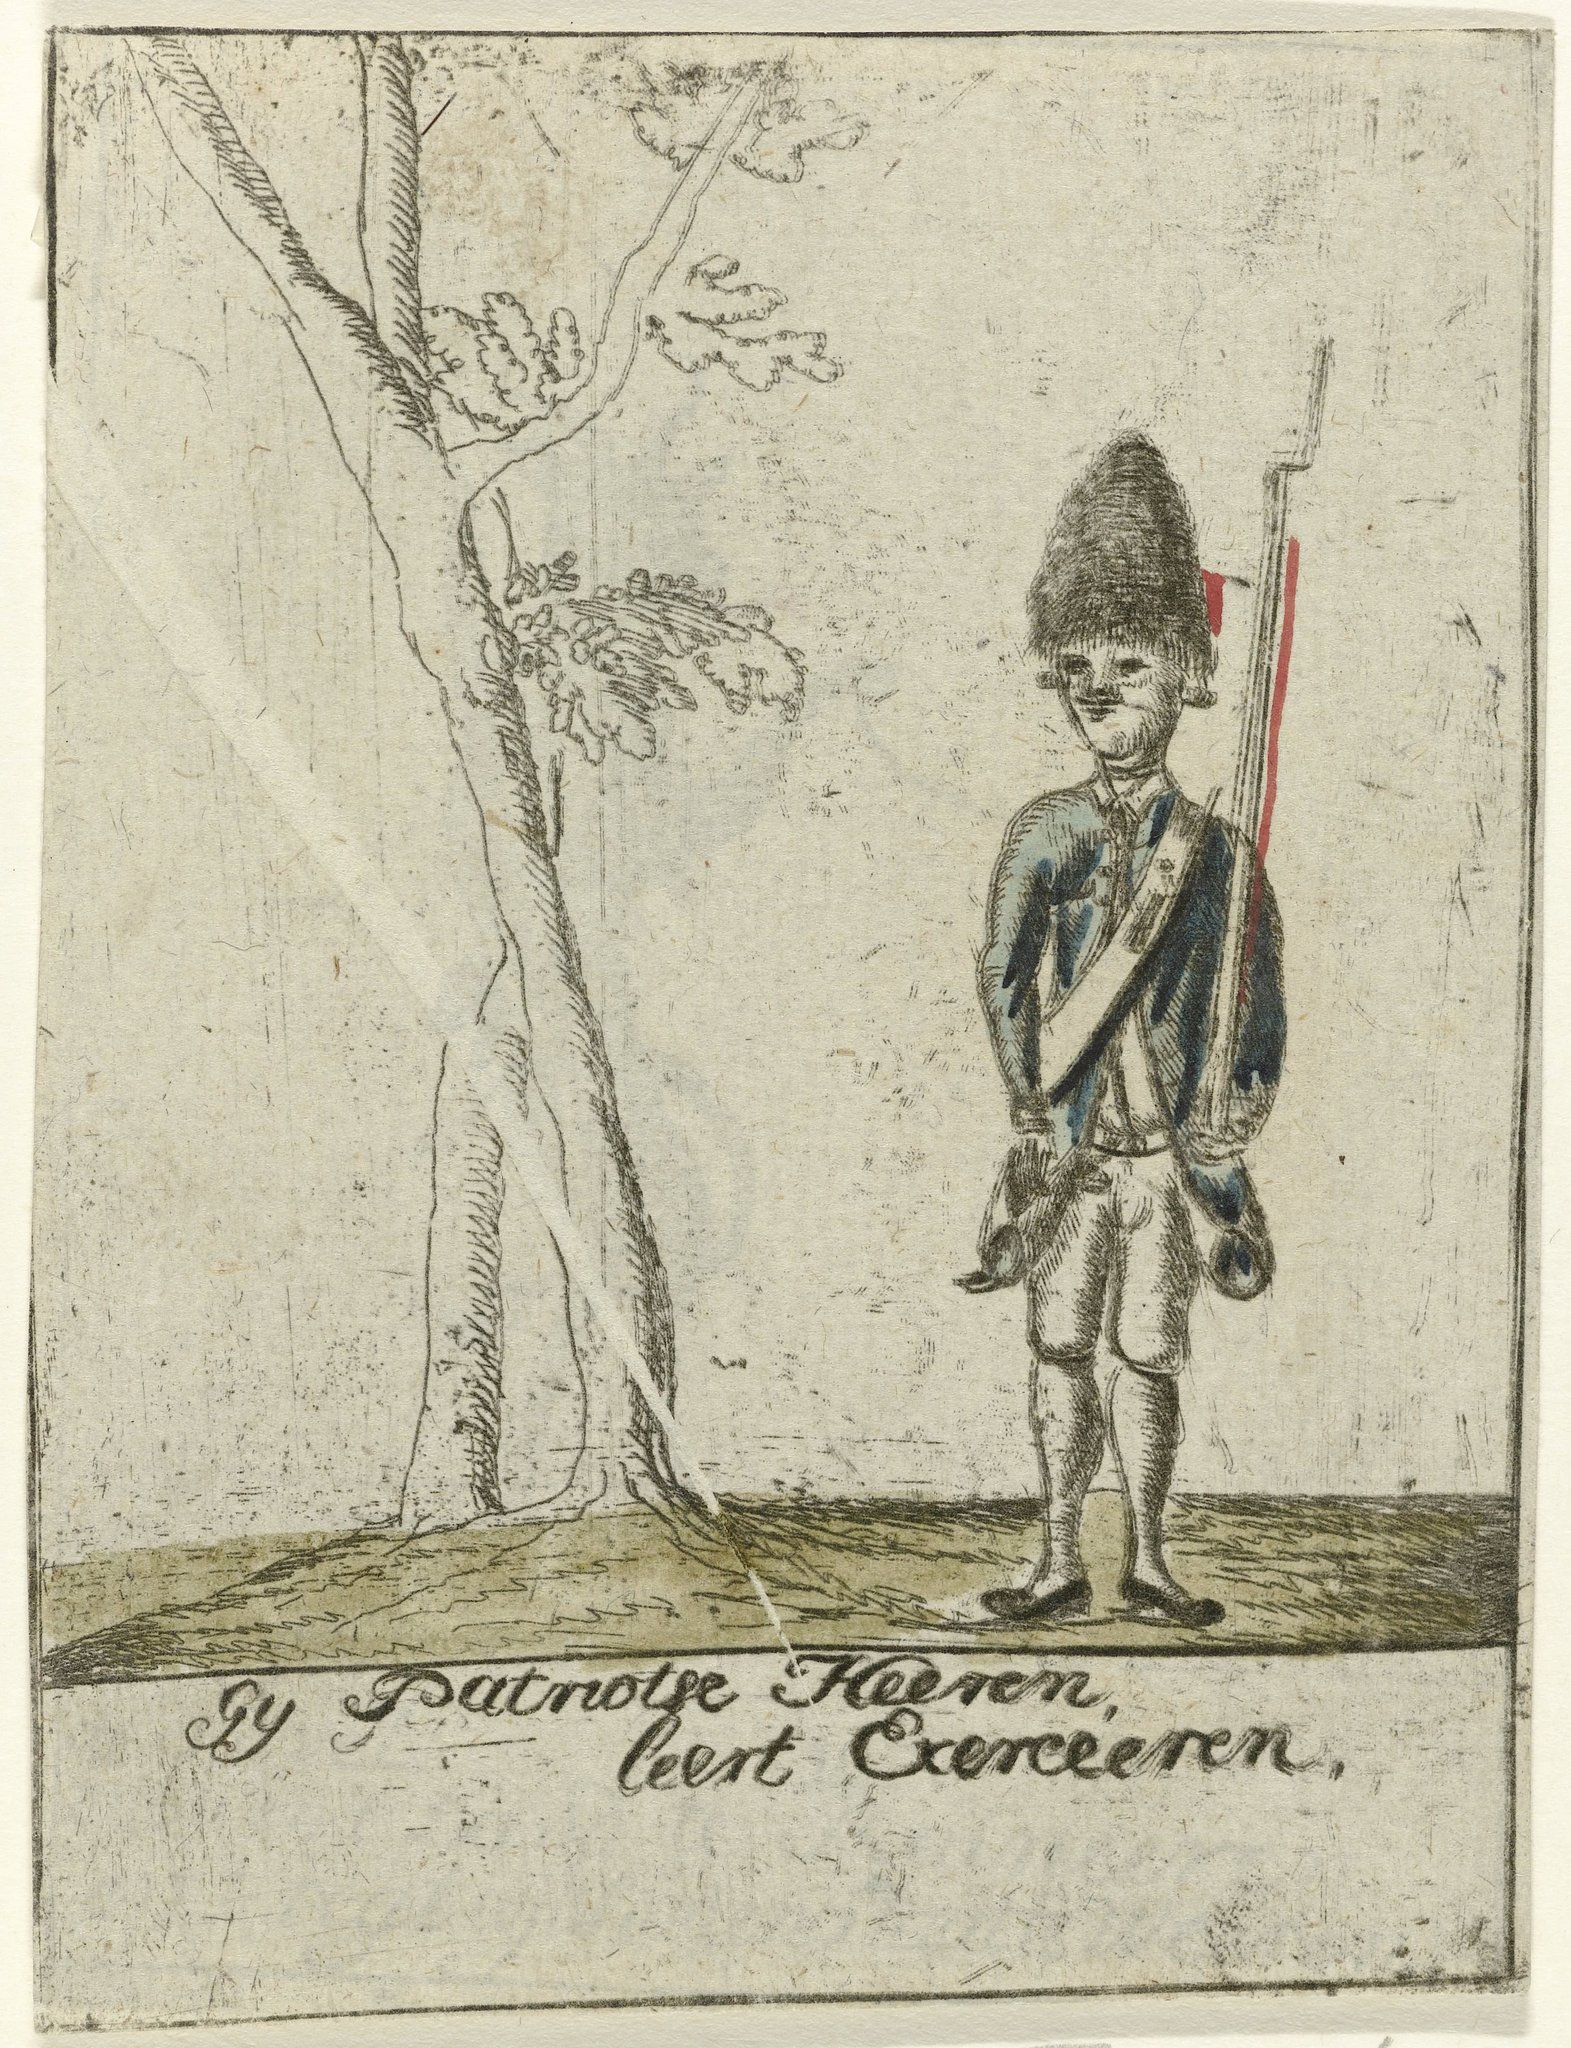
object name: cartoon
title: Patriotse Grenadier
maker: Anonymous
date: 1787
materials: paper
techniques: etching, hand coloring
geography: northern netherlands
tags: military training (+ citizen soldiery, civil guard, citizen militia), patriots (1780-1795)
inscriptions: collector's mark: Lugt 2228, inscription: ‘Gy Patriotse Heeren [de Duivel] leert [u] Exerceeren, [om u en 't Land te Ruineren en 't regt uyt Stad, en Staat te Weeren]’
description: Spotprent op een patriotse grenadier met berenmuts en geweer, staande naast twee bomen. Met tweeregelig versje. Transparant of doorkijkprent waarbij wanneer tegen het licht gehouden zichtbaar wordt dat de patriot aan de leiband van de duivel loopt en wordt het vers aangevuld tot vier regels. Bij de prent behoort een tekstblad.